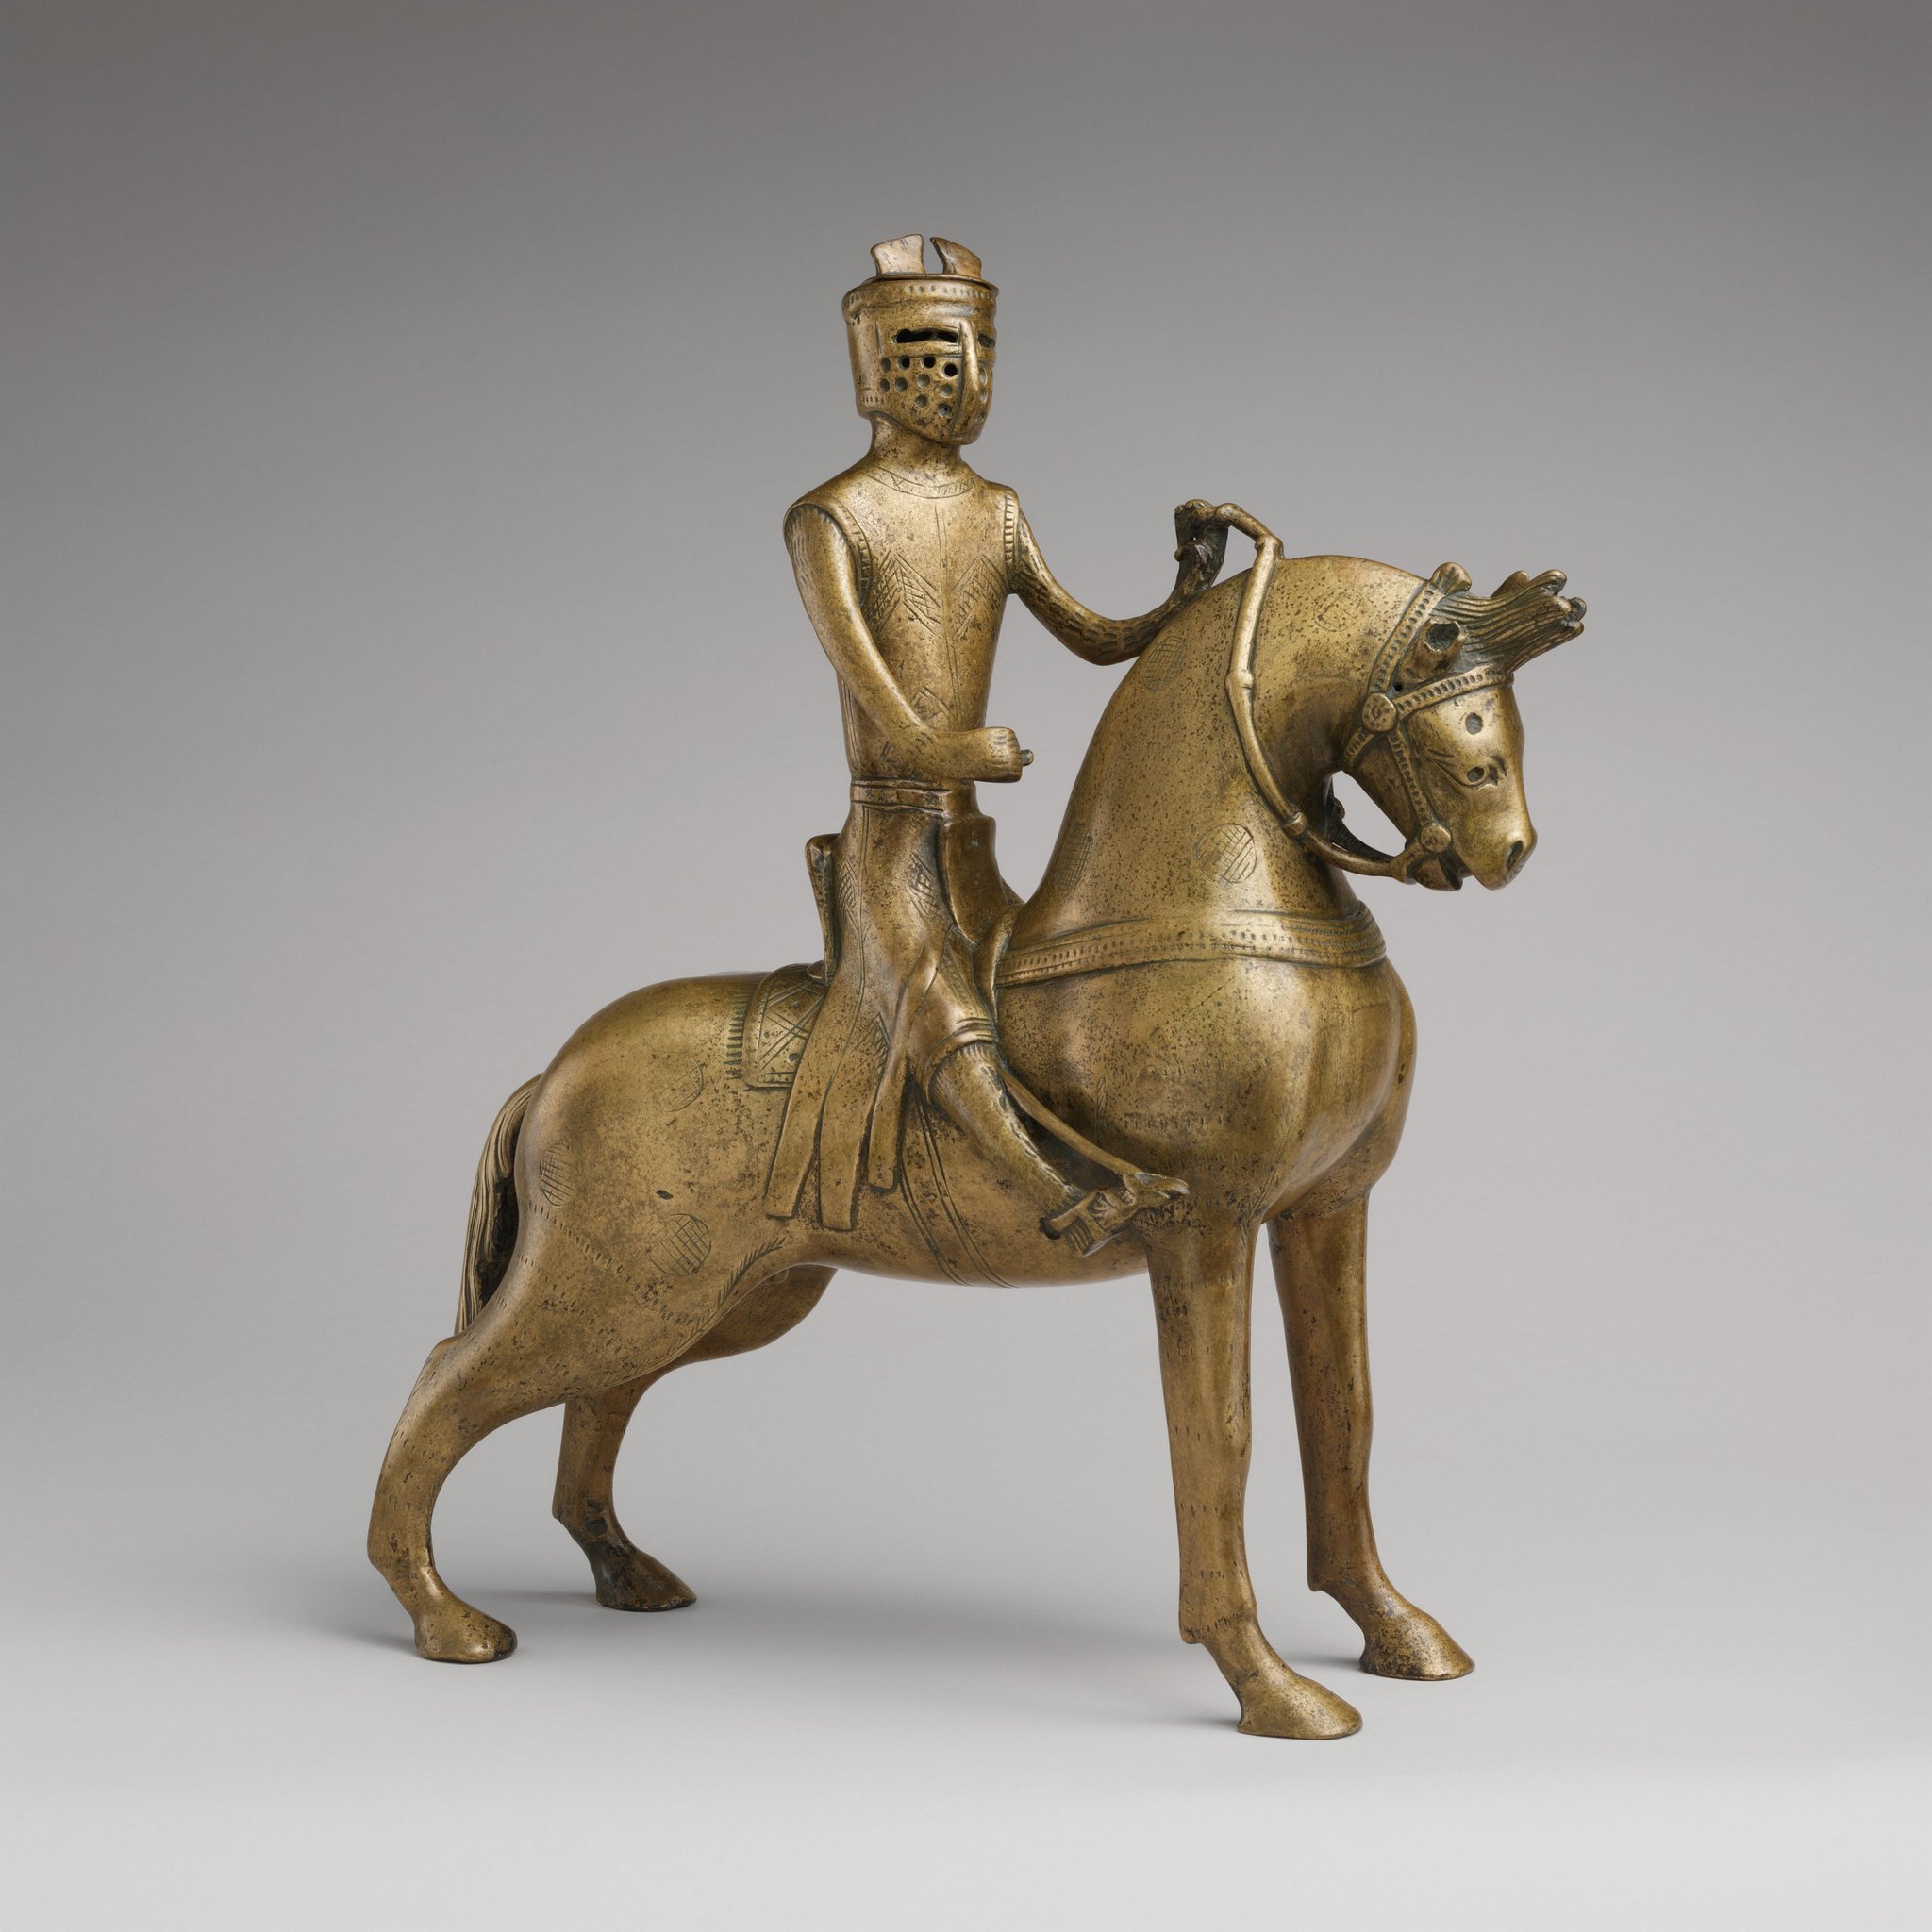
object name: aquamanile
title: Aquamanile in the Form of a Mounted Knight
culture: german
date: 1250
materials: copper alloy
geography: germany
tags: men,horses,knights